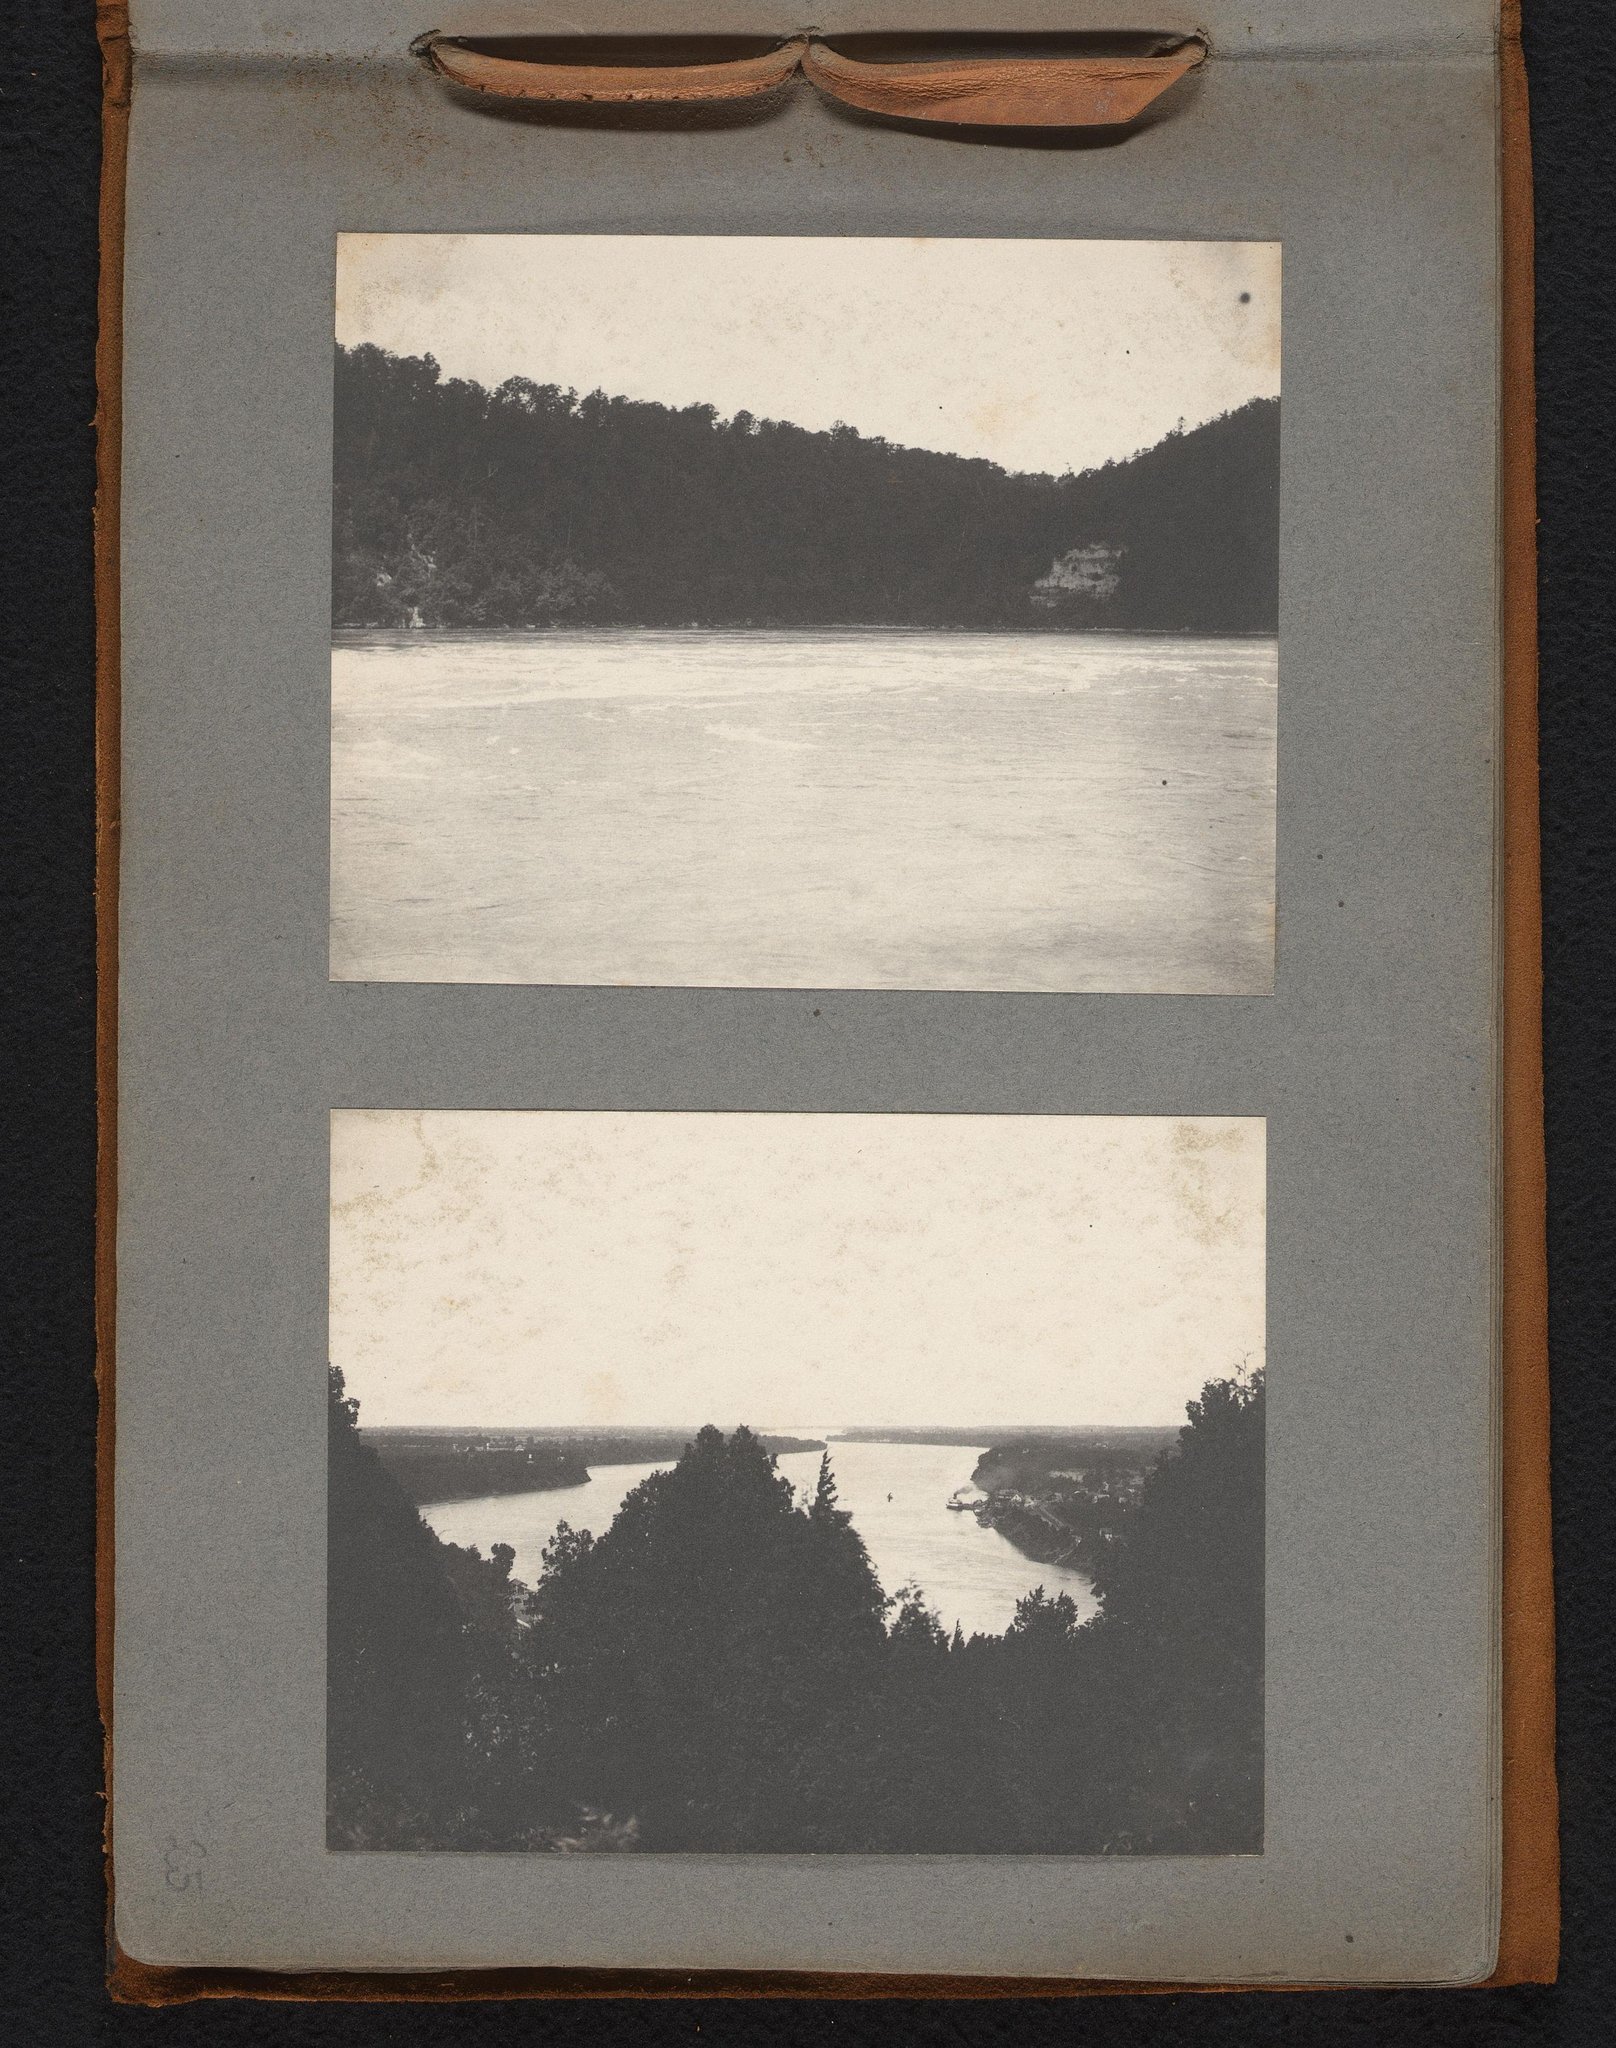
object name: photograph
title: Gezicht op een meer of rivier, mogelijk bij de Niagarawatervallen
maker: jan van der mey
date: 1902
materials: paper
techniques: gelatin silver print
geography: niagara falls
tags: river bank, lake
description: Deze foto's maken deel uit van een album.